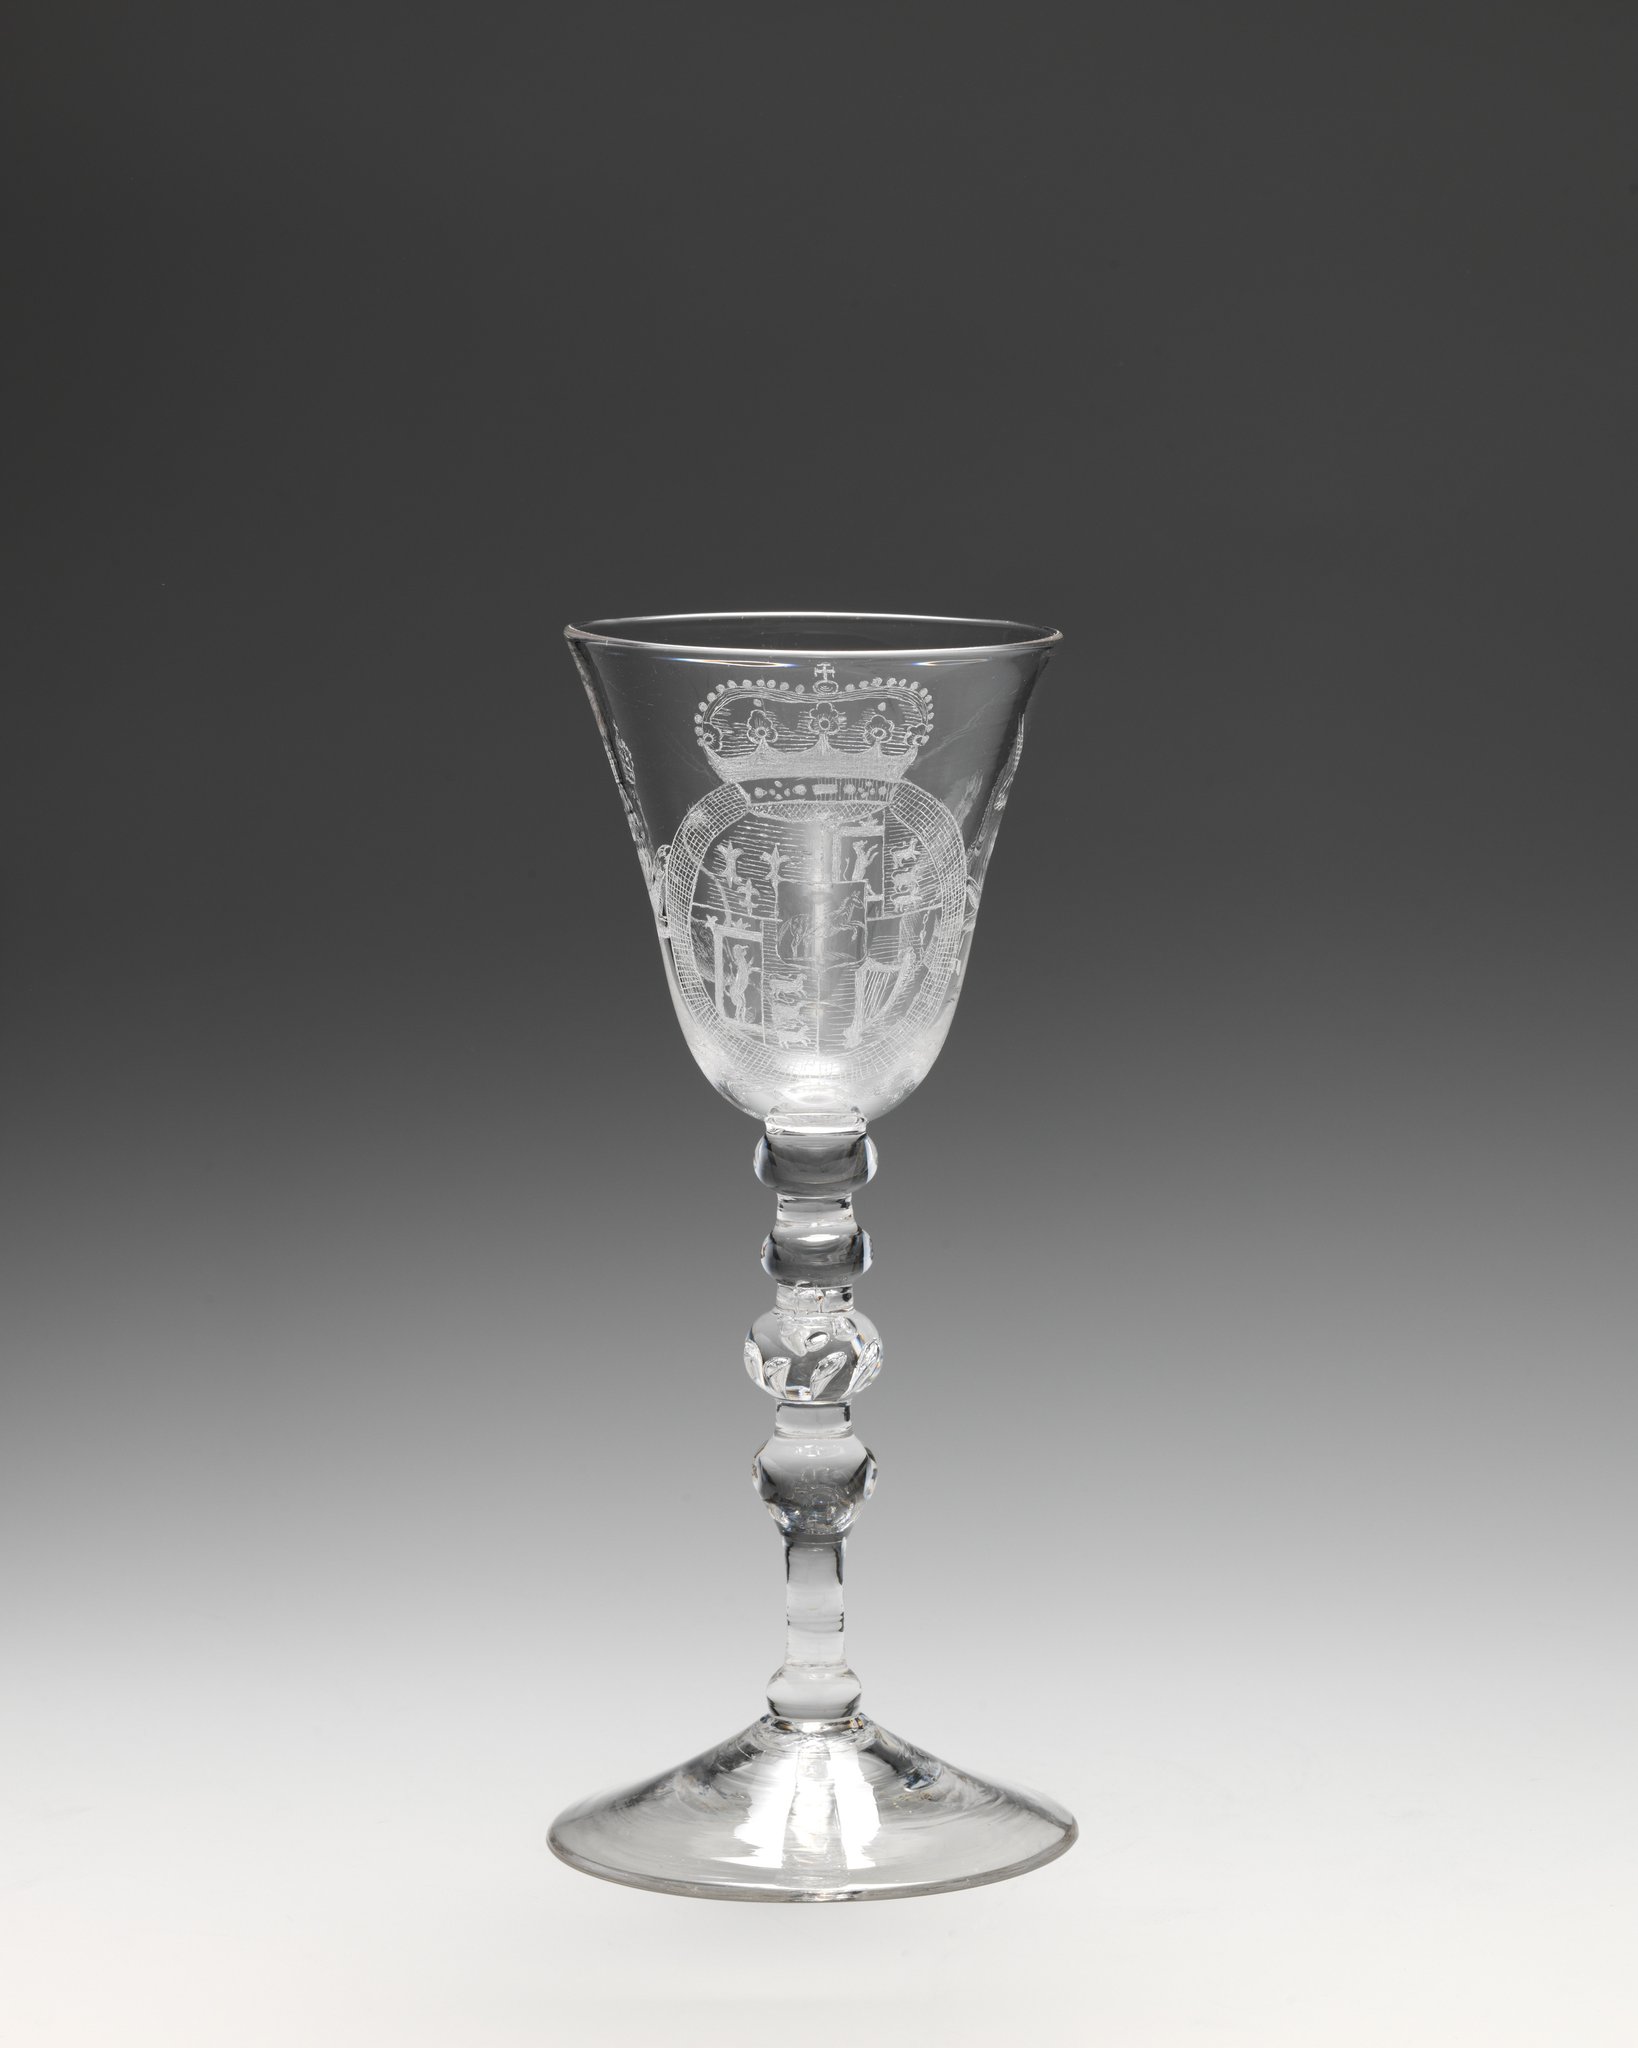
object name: wineglass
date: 1750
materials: glass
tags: coat of arms